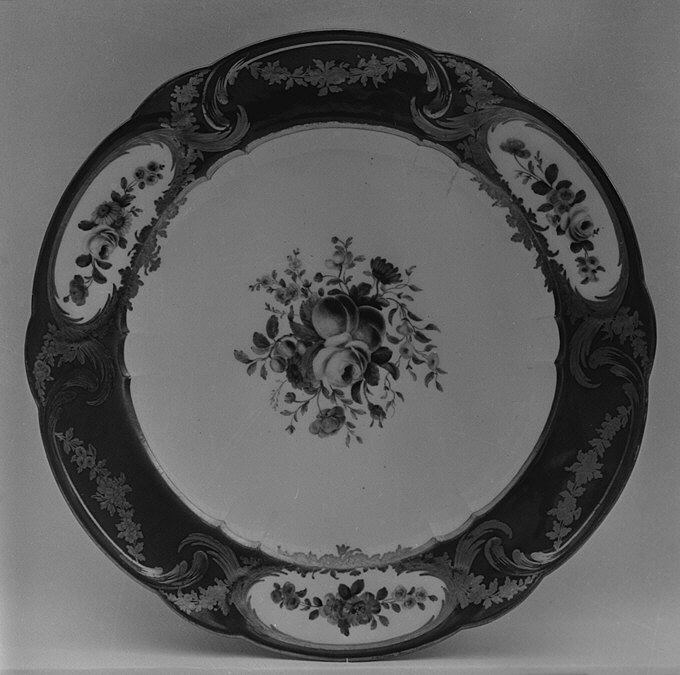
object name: plate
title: Plate (assiette à palmes) (1 of 102) (part of a service)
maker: sèvres manufactory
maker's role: manufactory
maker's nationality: french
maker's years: 1740-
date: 1787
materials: soft paste porcelain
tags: roses